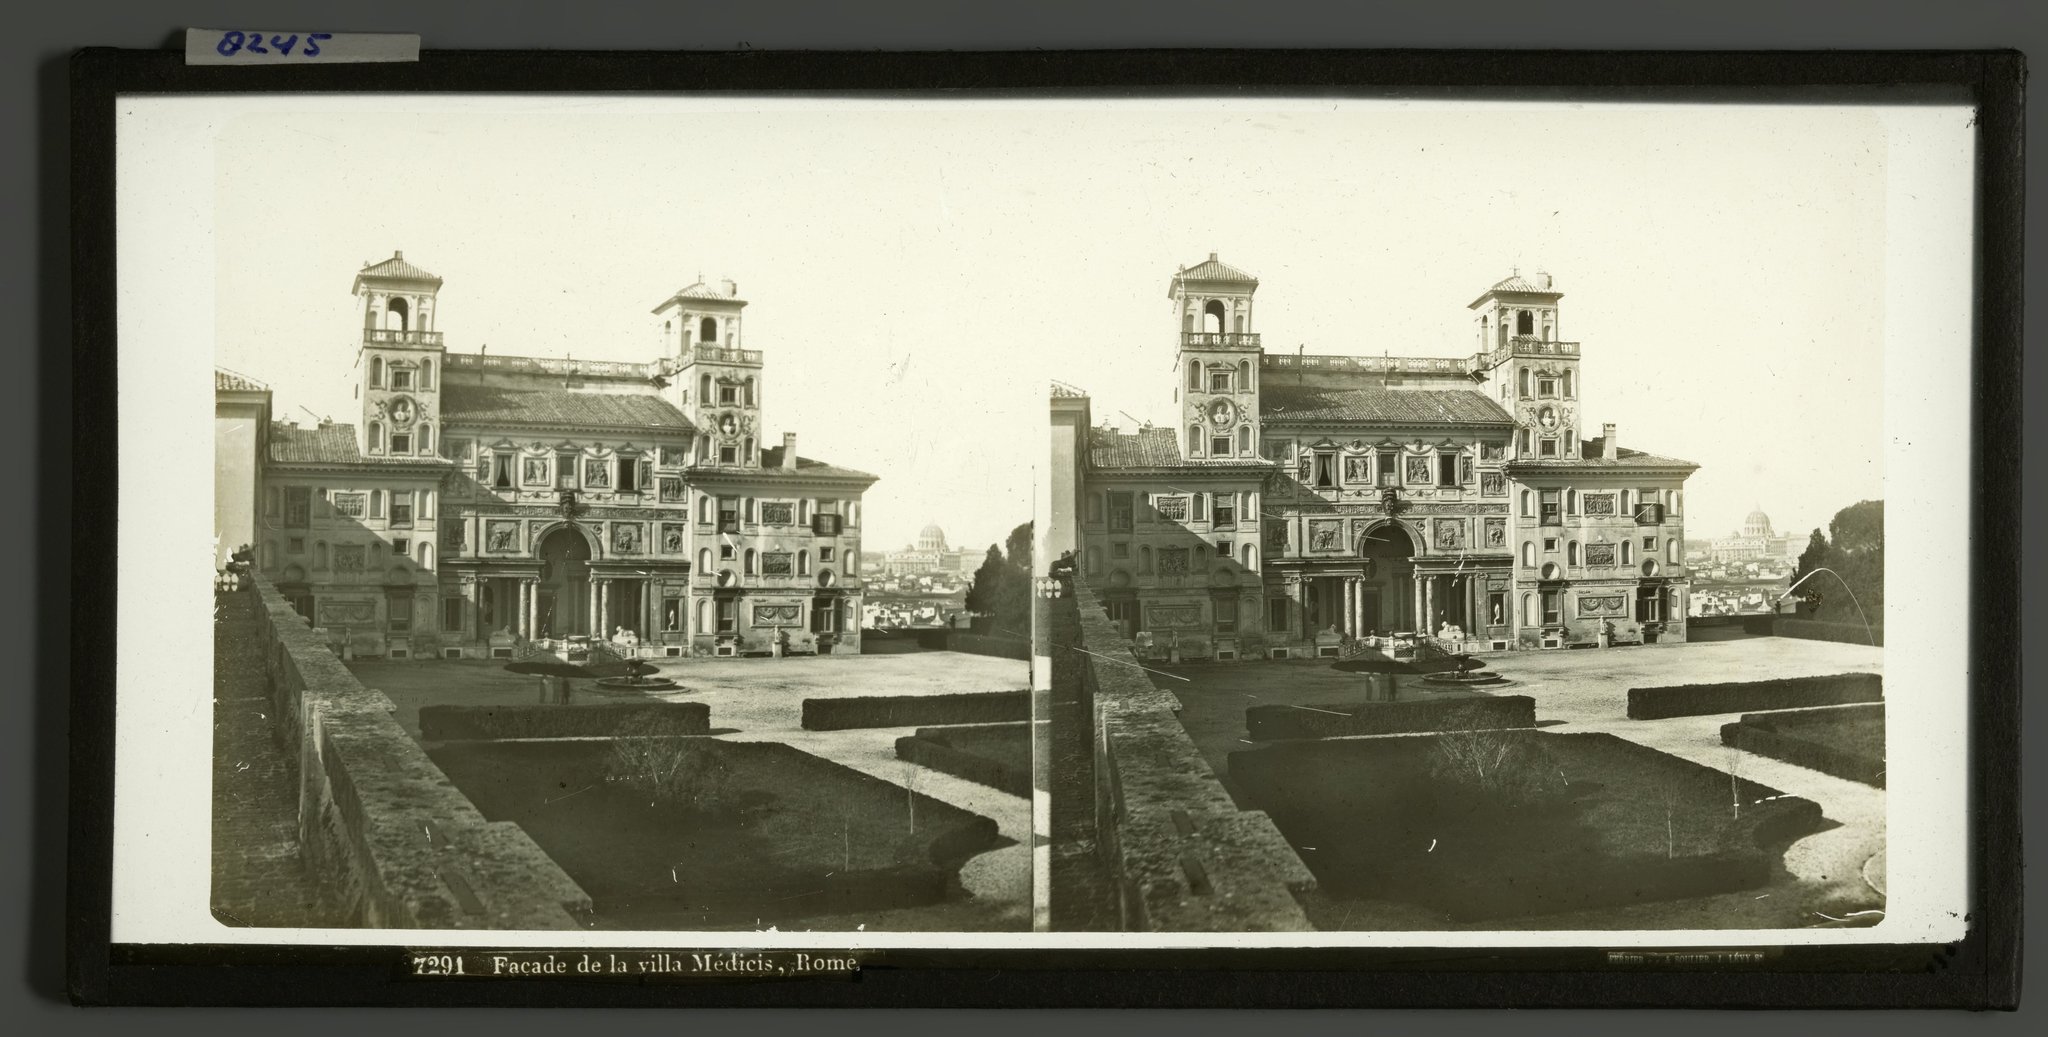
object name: stereoscopic photograph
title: Gezicht op de Villa Medici te Rome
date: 1860-1870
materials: glass, paper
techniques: slide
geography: rome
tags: city-view in general; 'veduta', villa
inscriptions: inscription: ‘7291, Façade de la villa Médicis, Rome’